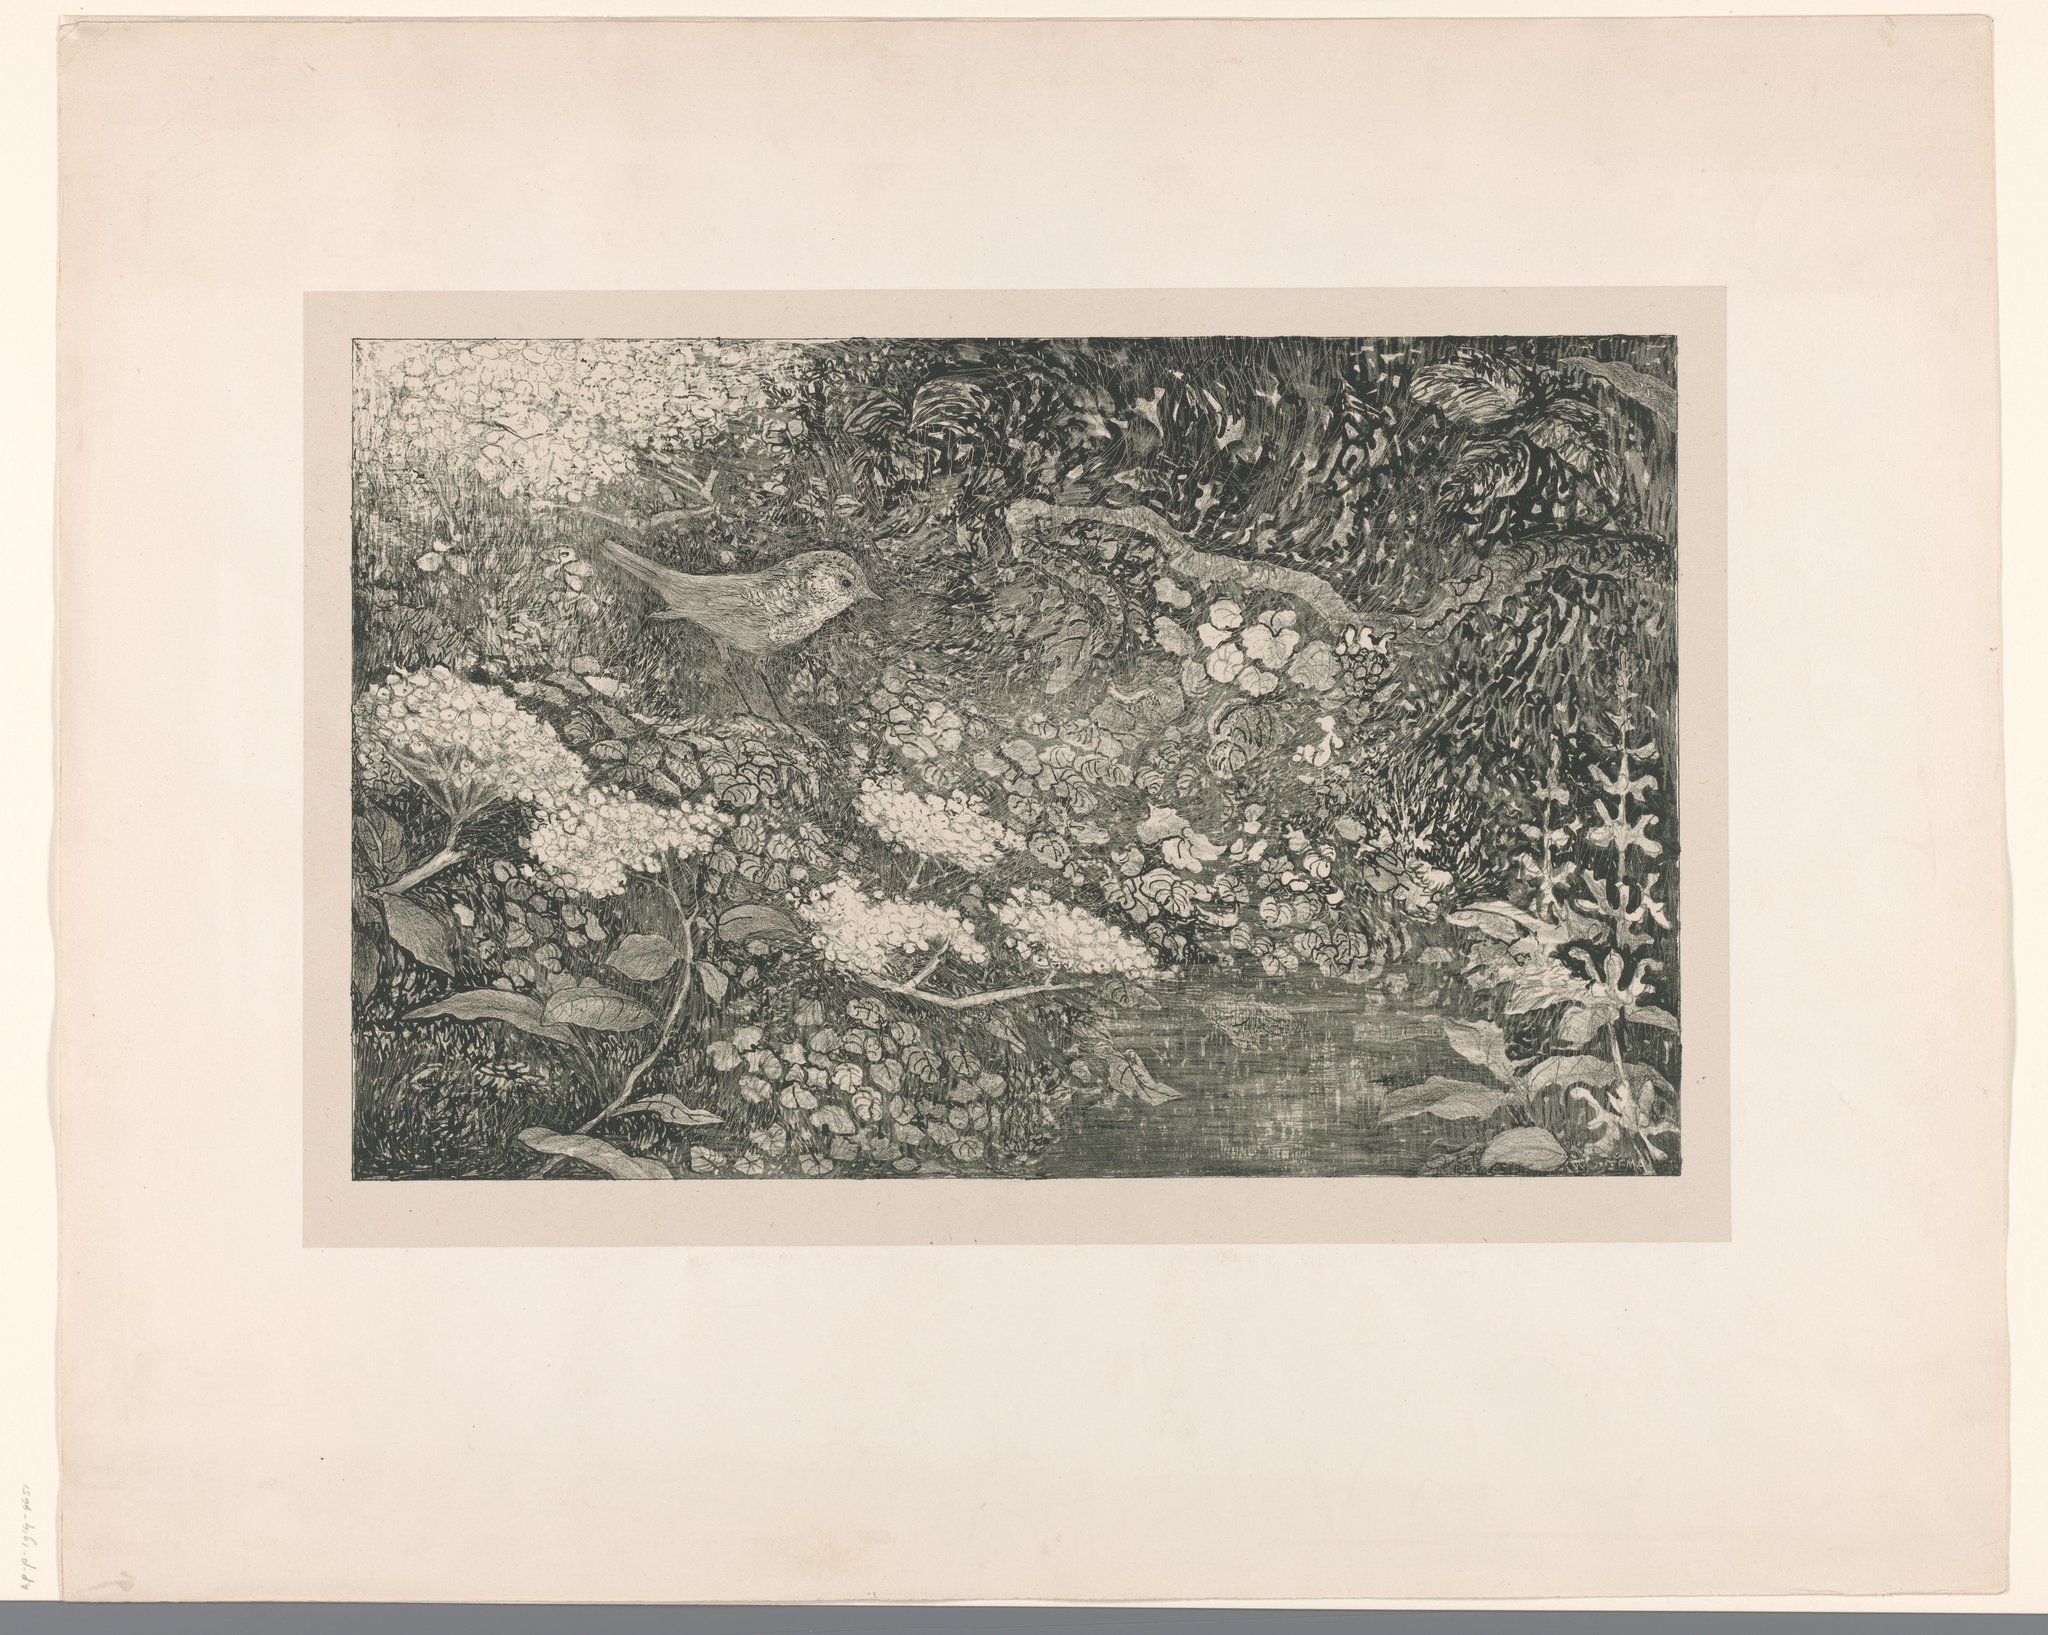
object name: print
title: Vogel in begroeiing aan het water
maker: theo van hoytema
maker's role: draughtsman, painter, print maker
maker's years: 1863-1917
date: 1911-1914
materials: paper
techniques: lithograph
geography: netherlands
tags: plantation, birds, pond, pool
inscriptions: collector's mark: Lugt 2233